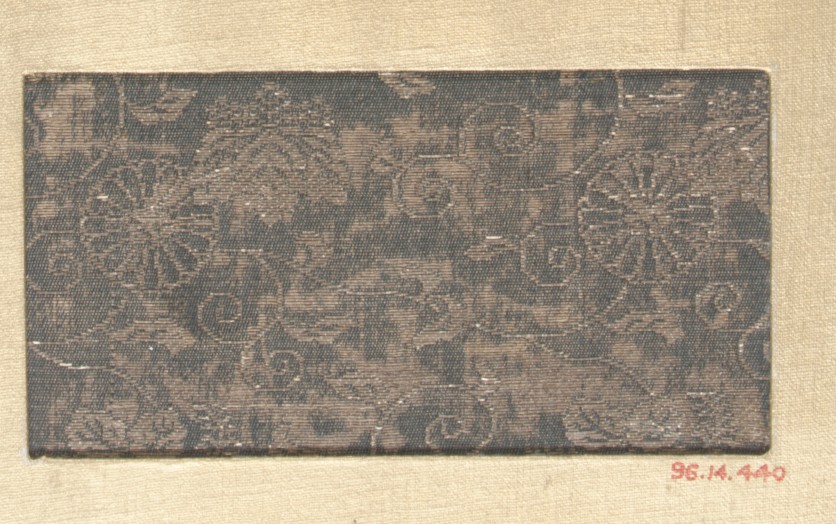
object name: piece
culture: japanese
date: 1701-1900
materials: silk